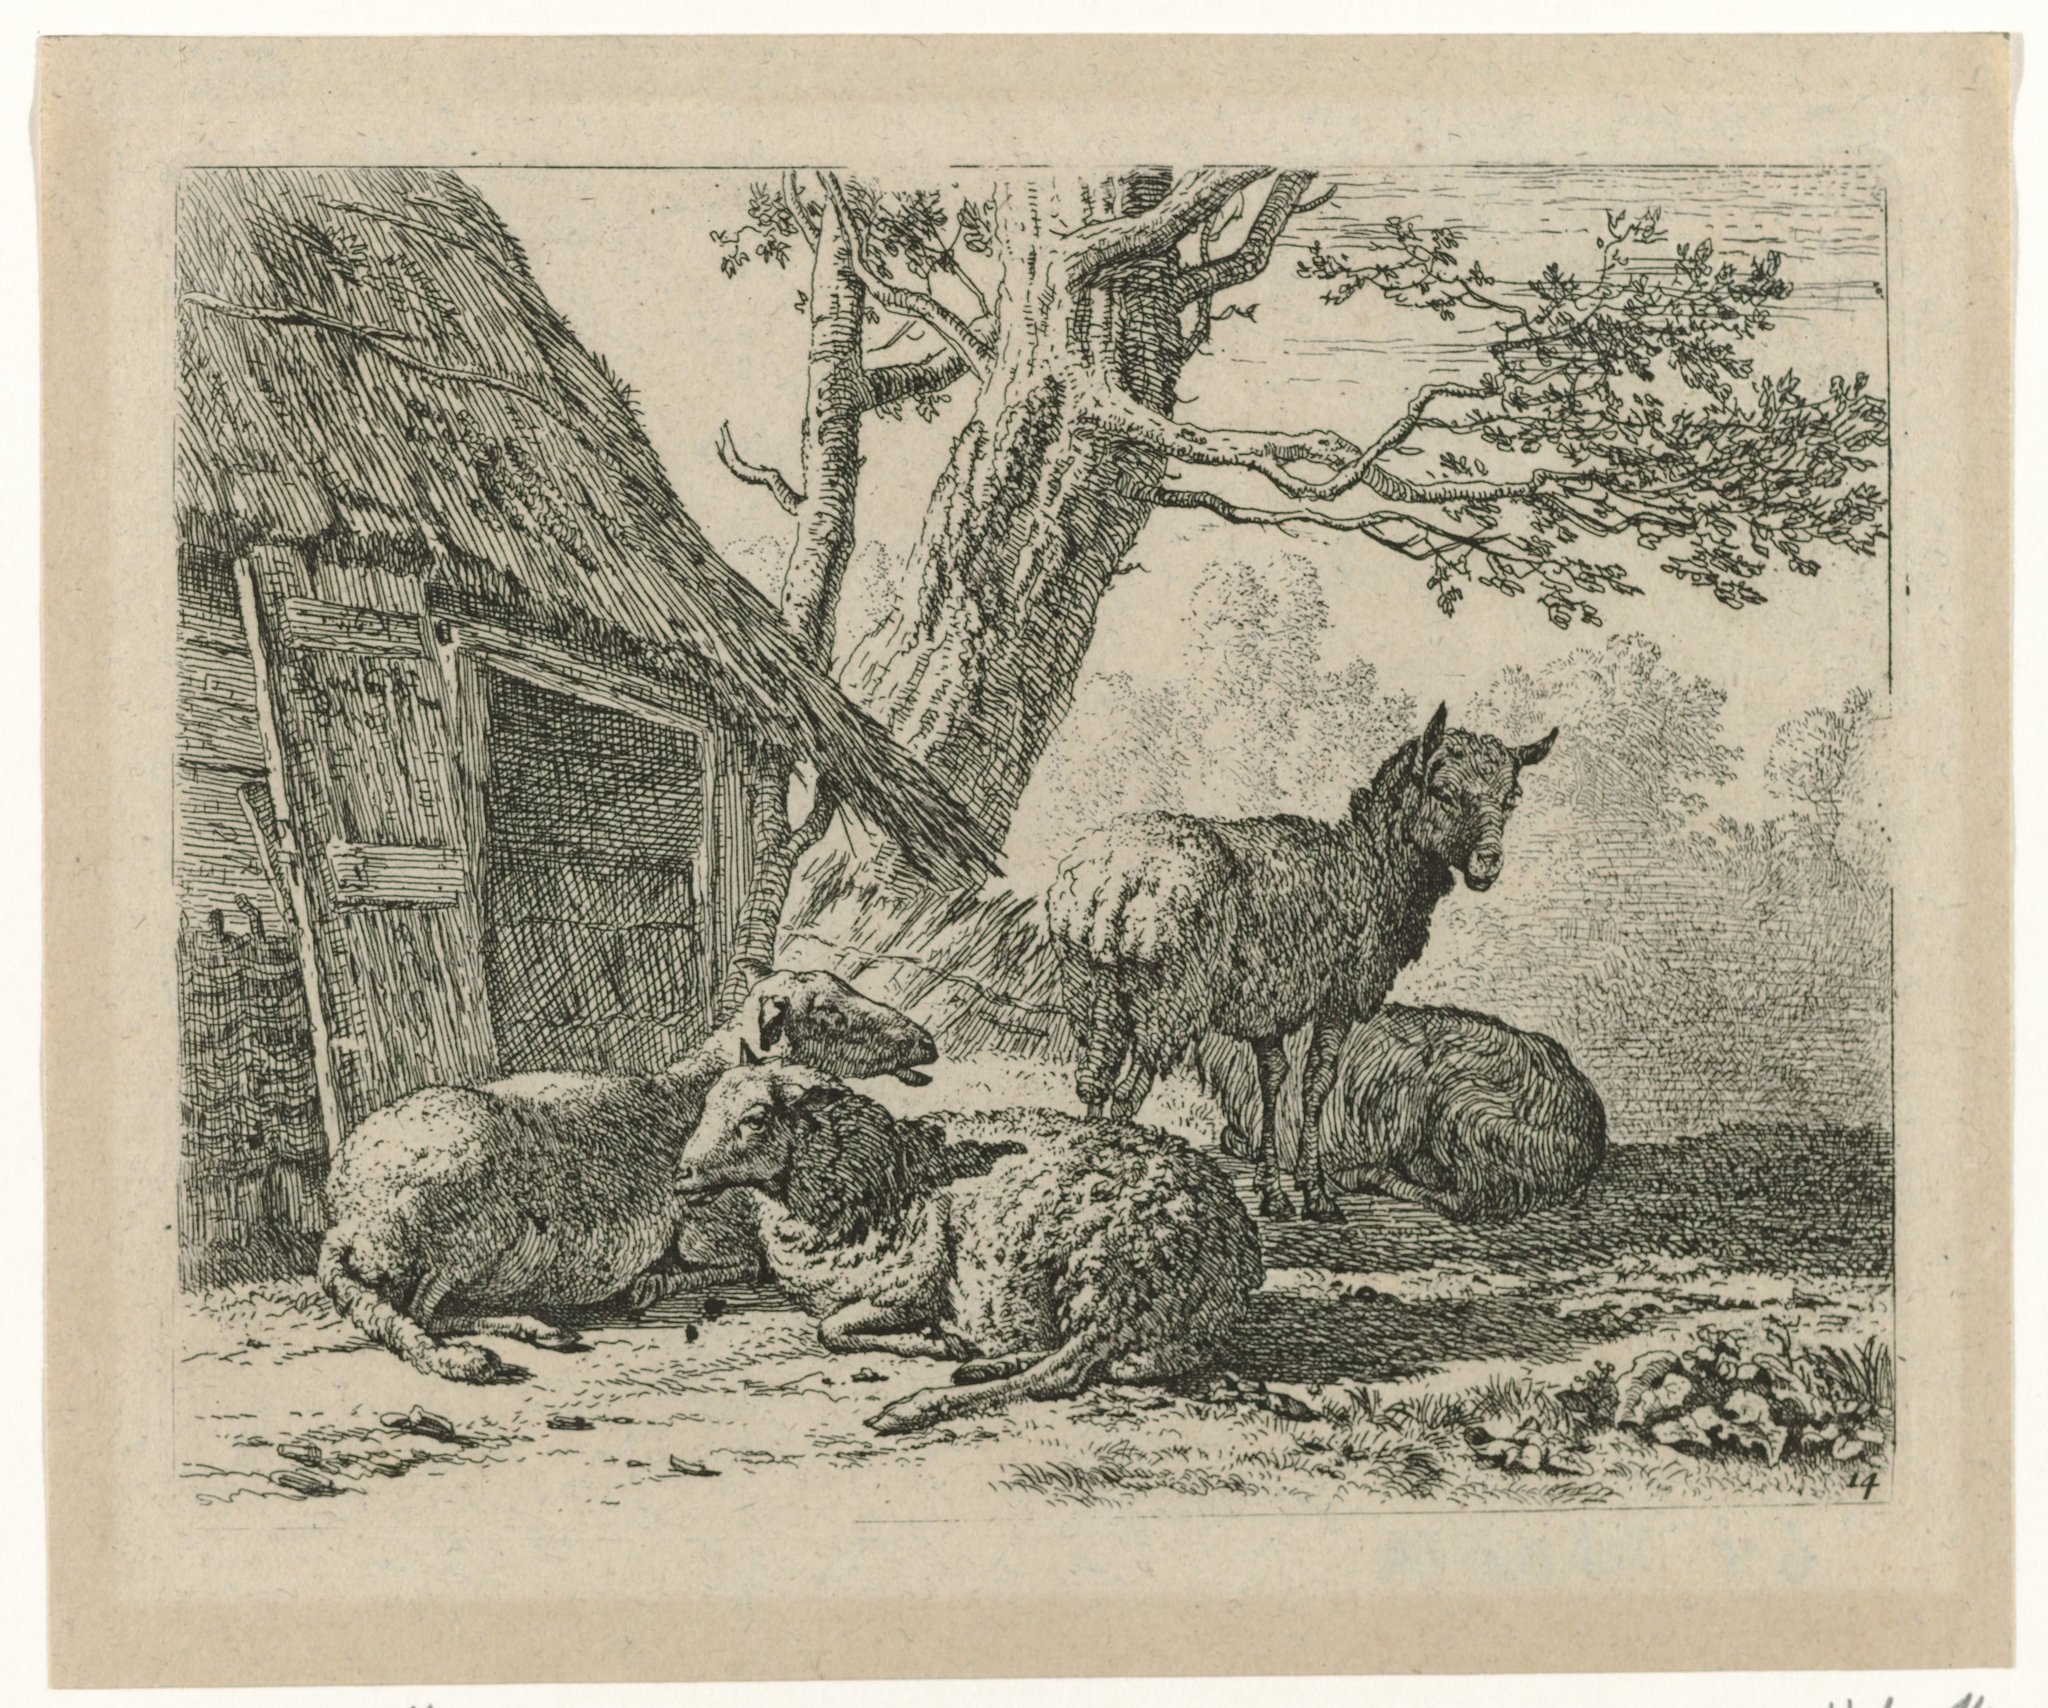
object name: print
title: Vier schapen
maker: karel du jardin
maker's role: draughtsman, painter, print maker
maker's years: 1626-1678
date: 1658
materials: paper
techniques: etching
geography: the hague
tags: sheep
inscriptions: collector's mark: Lugt 2228